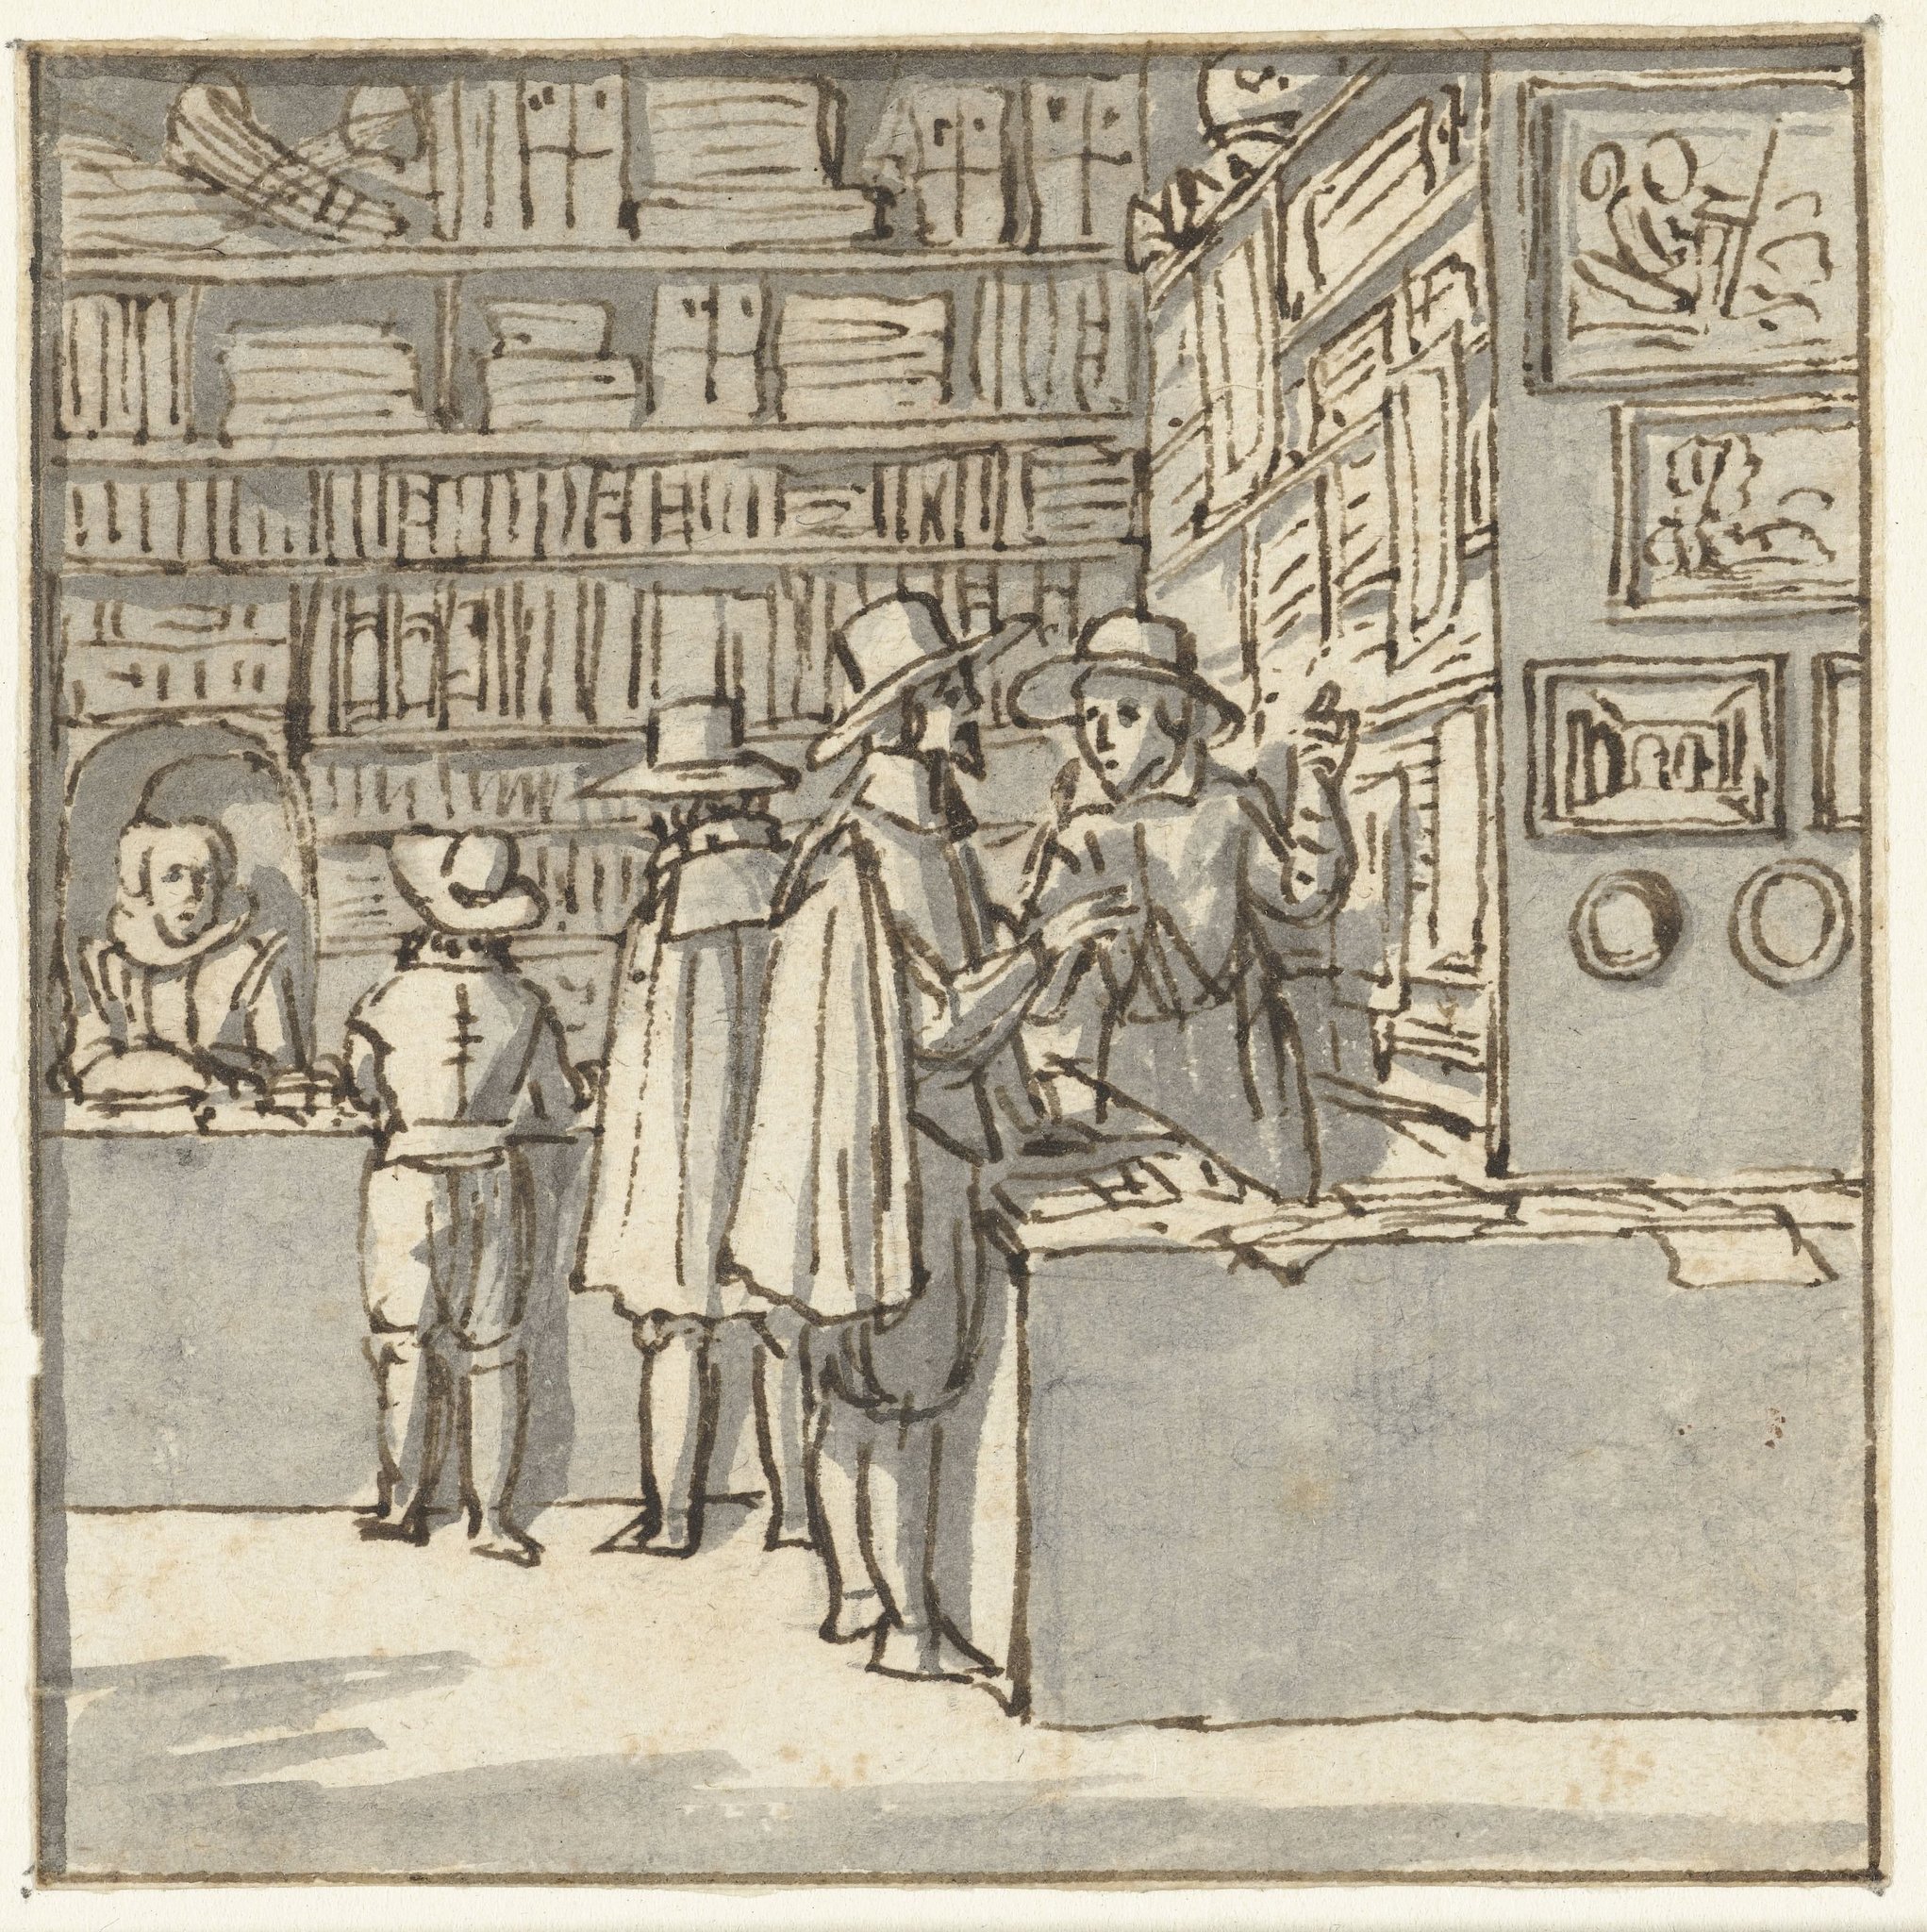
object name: drawing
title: Interior of a Bookshop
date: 1628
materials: ink, paper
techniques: brush, pen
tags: drawing, sketch, book with clasps, counter ~ shop, adult woman, adult man, book, art dealer, picture, painting, book-shop, bookseller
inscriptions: collector's mark: Lugt 2228, inscription: ‘de Braay’, collector's mark: Lugt 2135, inscription: ‘S. de Bray’, inscription: ‘N 3634.’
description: Interieur van een vermoedelijk Haarlemse boek- en kunsthandel. Links, achter de toonbank zit of staat de winkelierster, met daarvoor twee klanten. Achter de toonbank stellingen met pakken papier en enkele boeken met de snede en de sloten naar voren, zoals in die tijd gebruikelijk. Rechts van het midden een klant in gesprek met de winkelier. Aan de wand hangen vermoedelijk schilderijen, prenten en/of tekeningen.